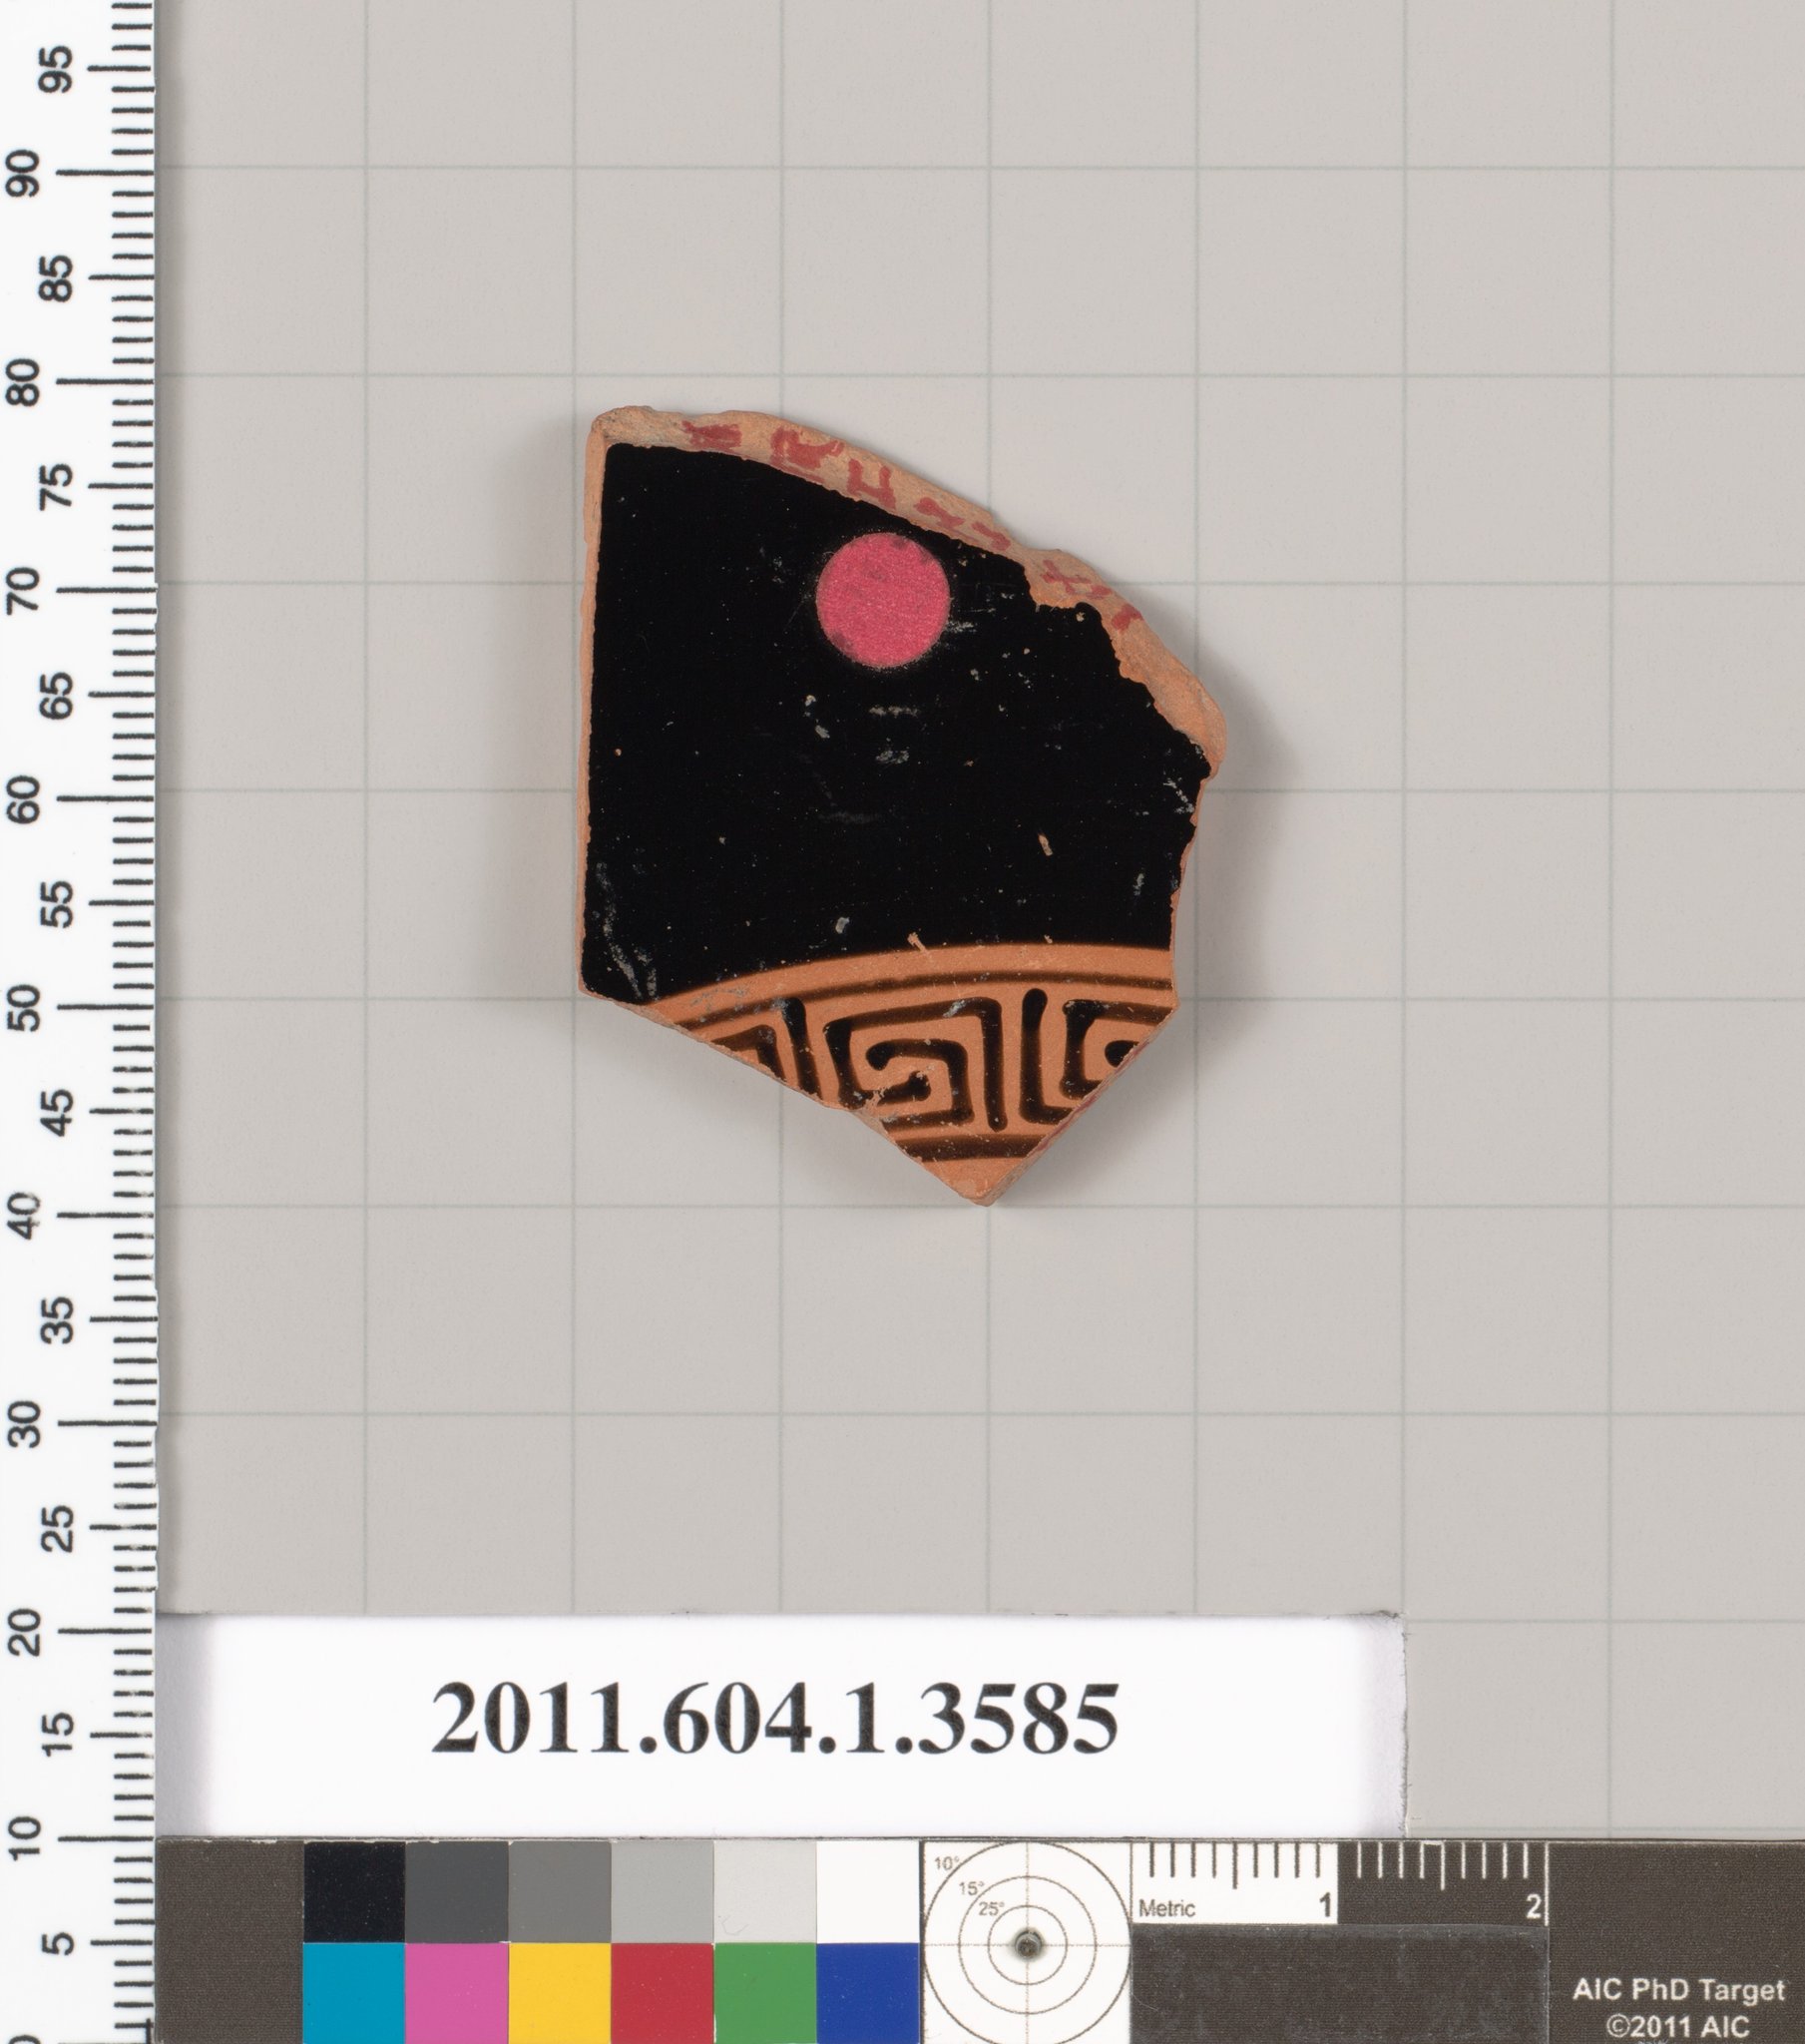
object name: kylix fragment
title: Terracotta fragment of a kylix (drinking cup)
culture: greek, attic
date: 490-470 BCE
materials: terracotta